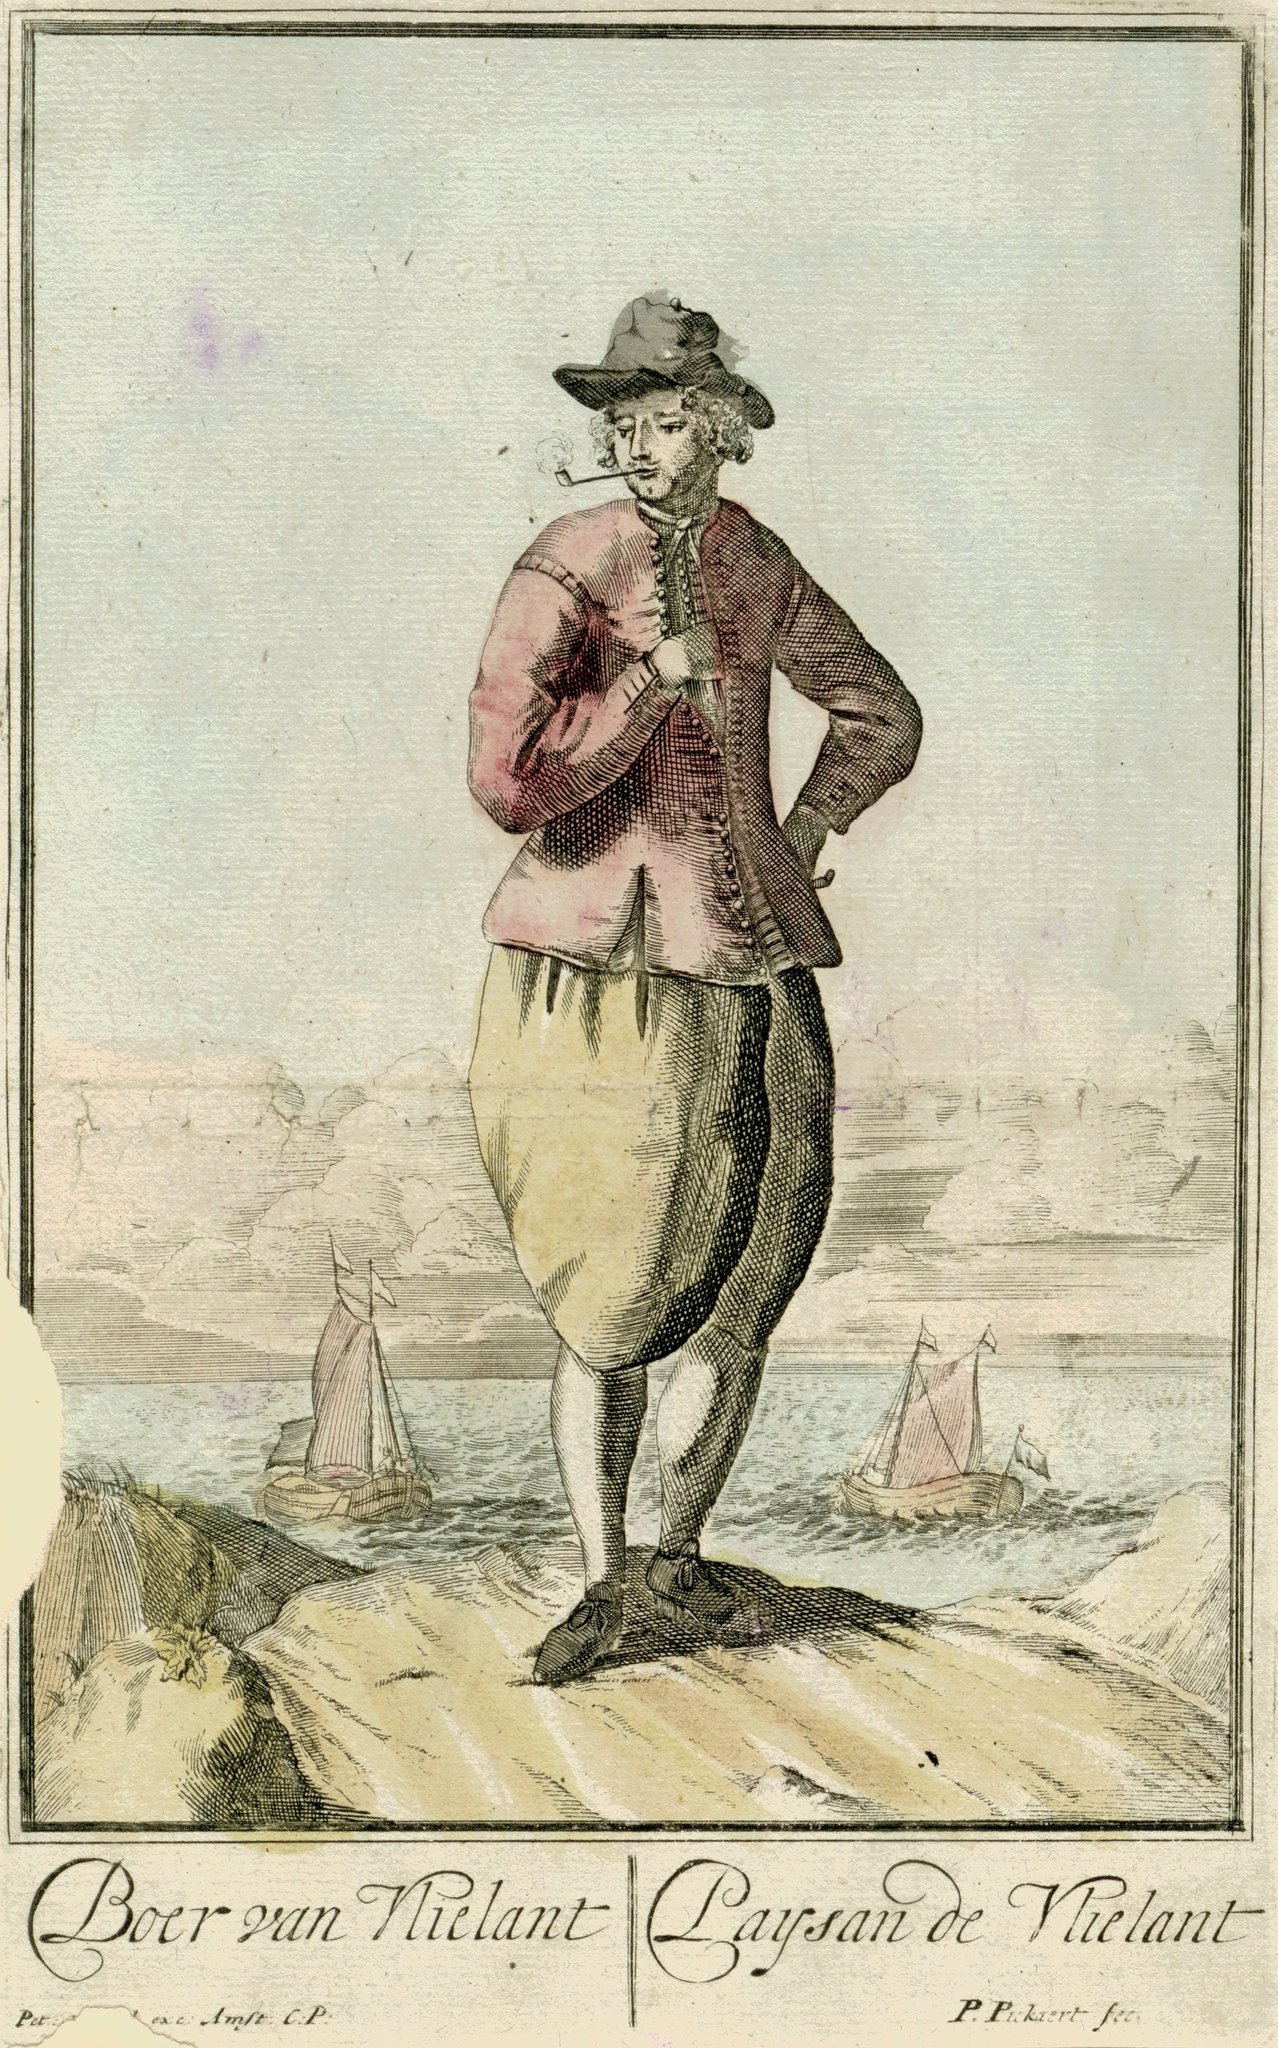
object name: print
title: Nederlandse klederdrachten naar Pieter van den Berge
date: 1689-1713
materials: paper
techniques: engraving, etching, hand coloring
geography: amsterdam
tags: pipe ~ tobacco, farmers, folk costume, regional costume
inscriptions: collector's mark: Lugt 2228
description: Boer afkomstig van het eiland Vlieland staat met een pijp in zijn mond aan de kust. Achter hem de zee met twee schepen. Prent uit een serie prenten naar Pieter van den Berge met dorpelingen die klederdrachten dragen.